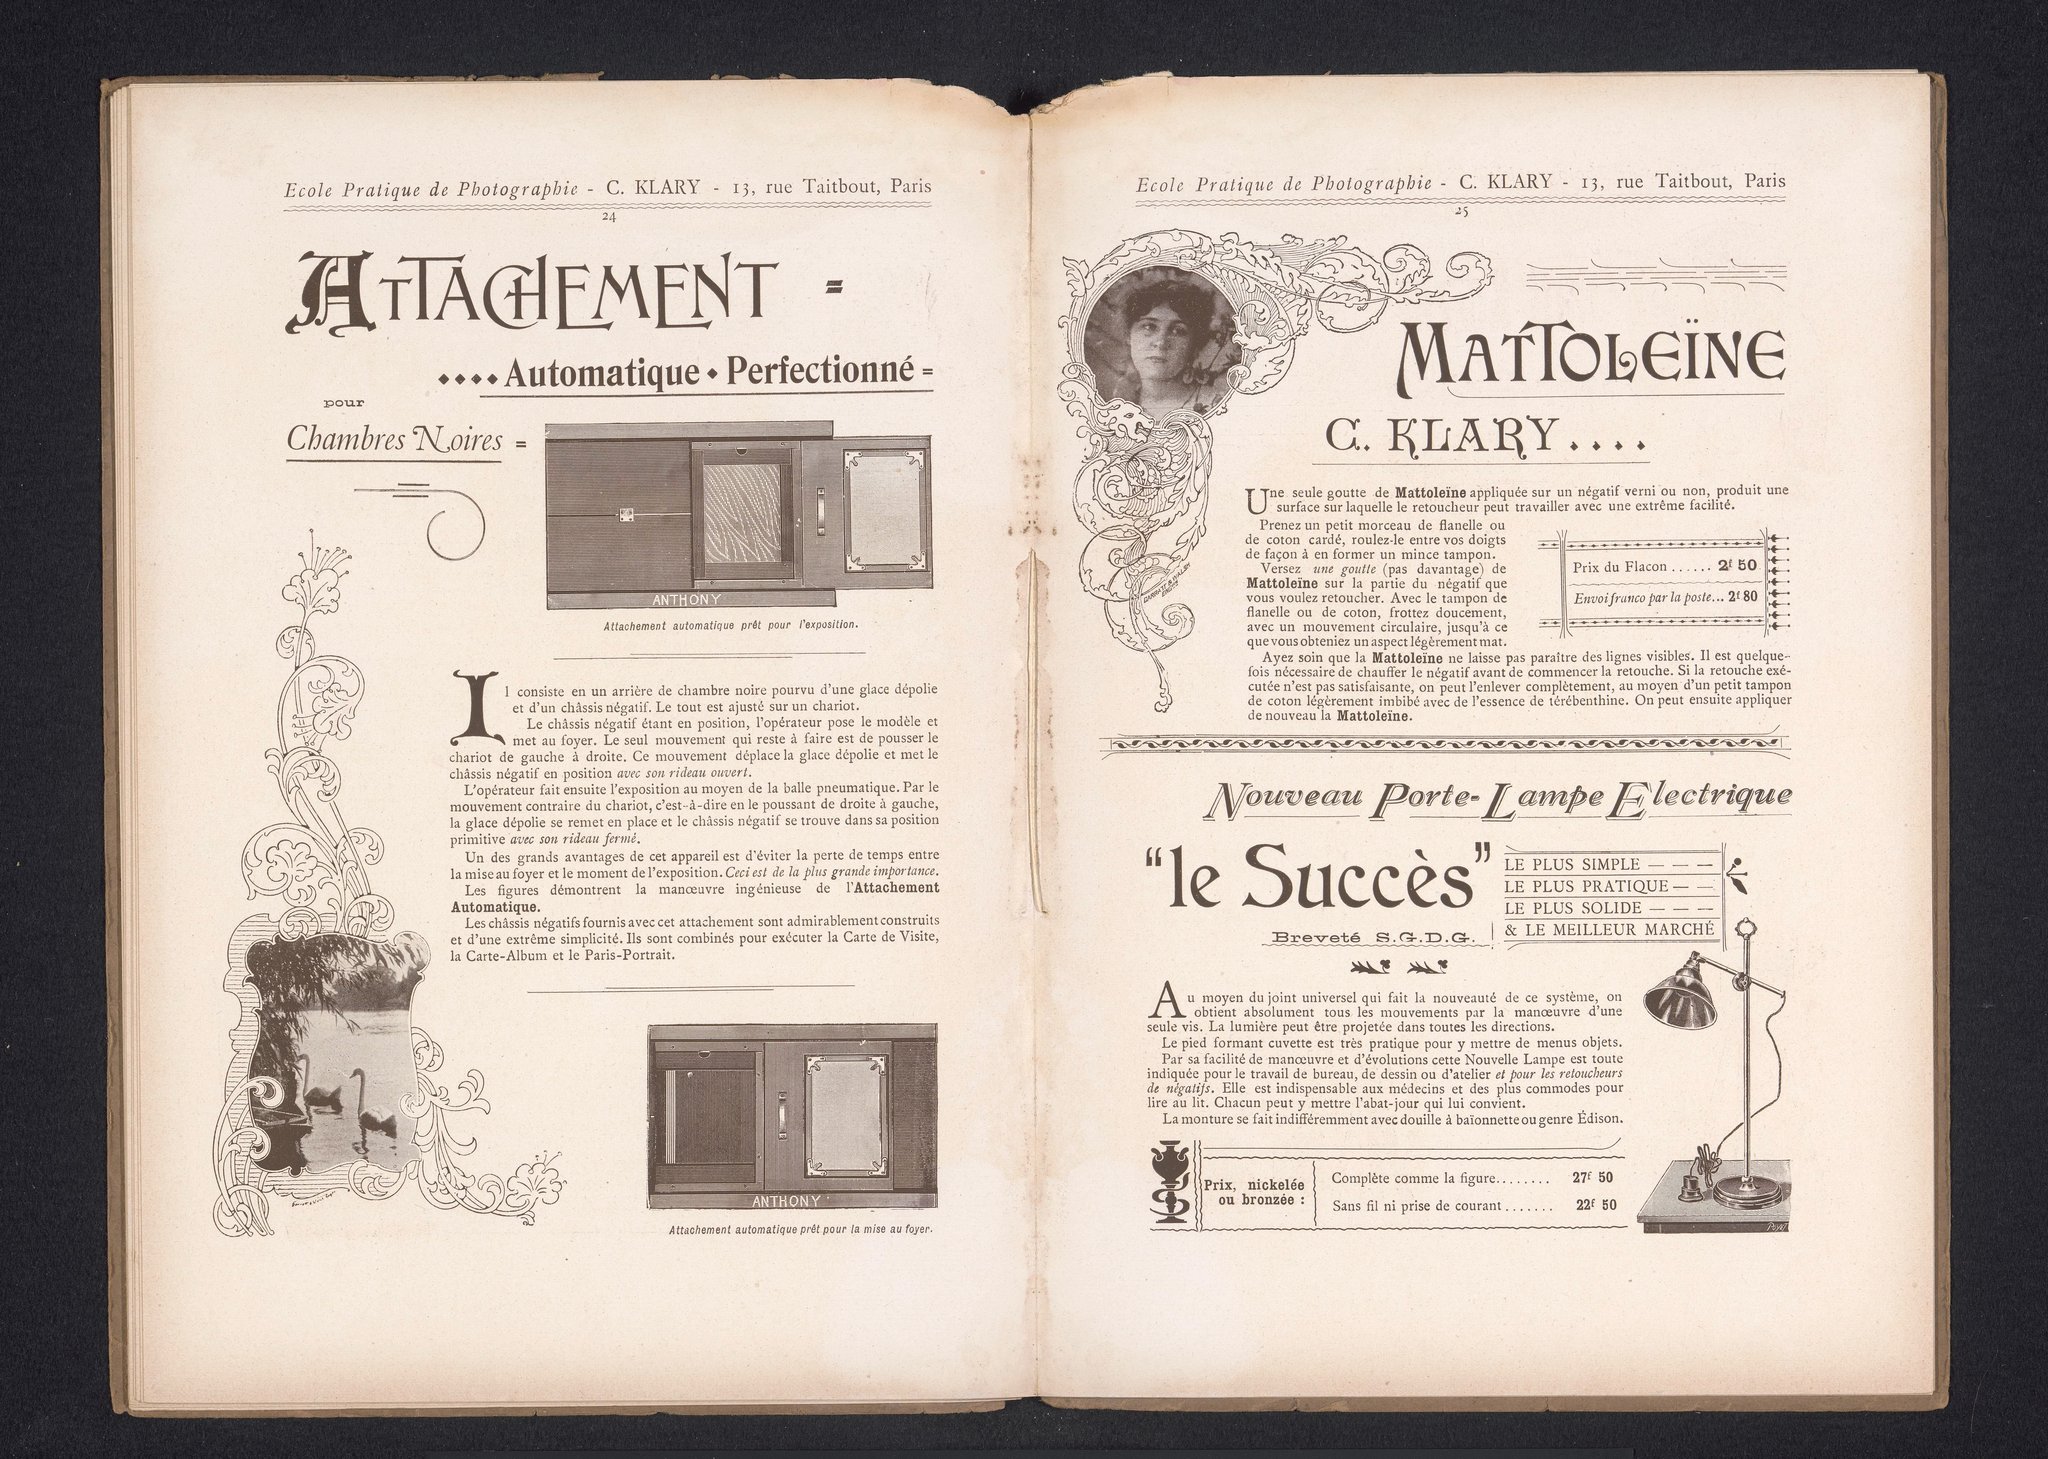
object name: page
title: Twee zwanen op het water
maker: charles louis klary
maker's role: fotograaf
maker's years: 1837-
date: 1890-1900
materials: paper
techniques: autotype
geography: paris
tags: water-birds: swan